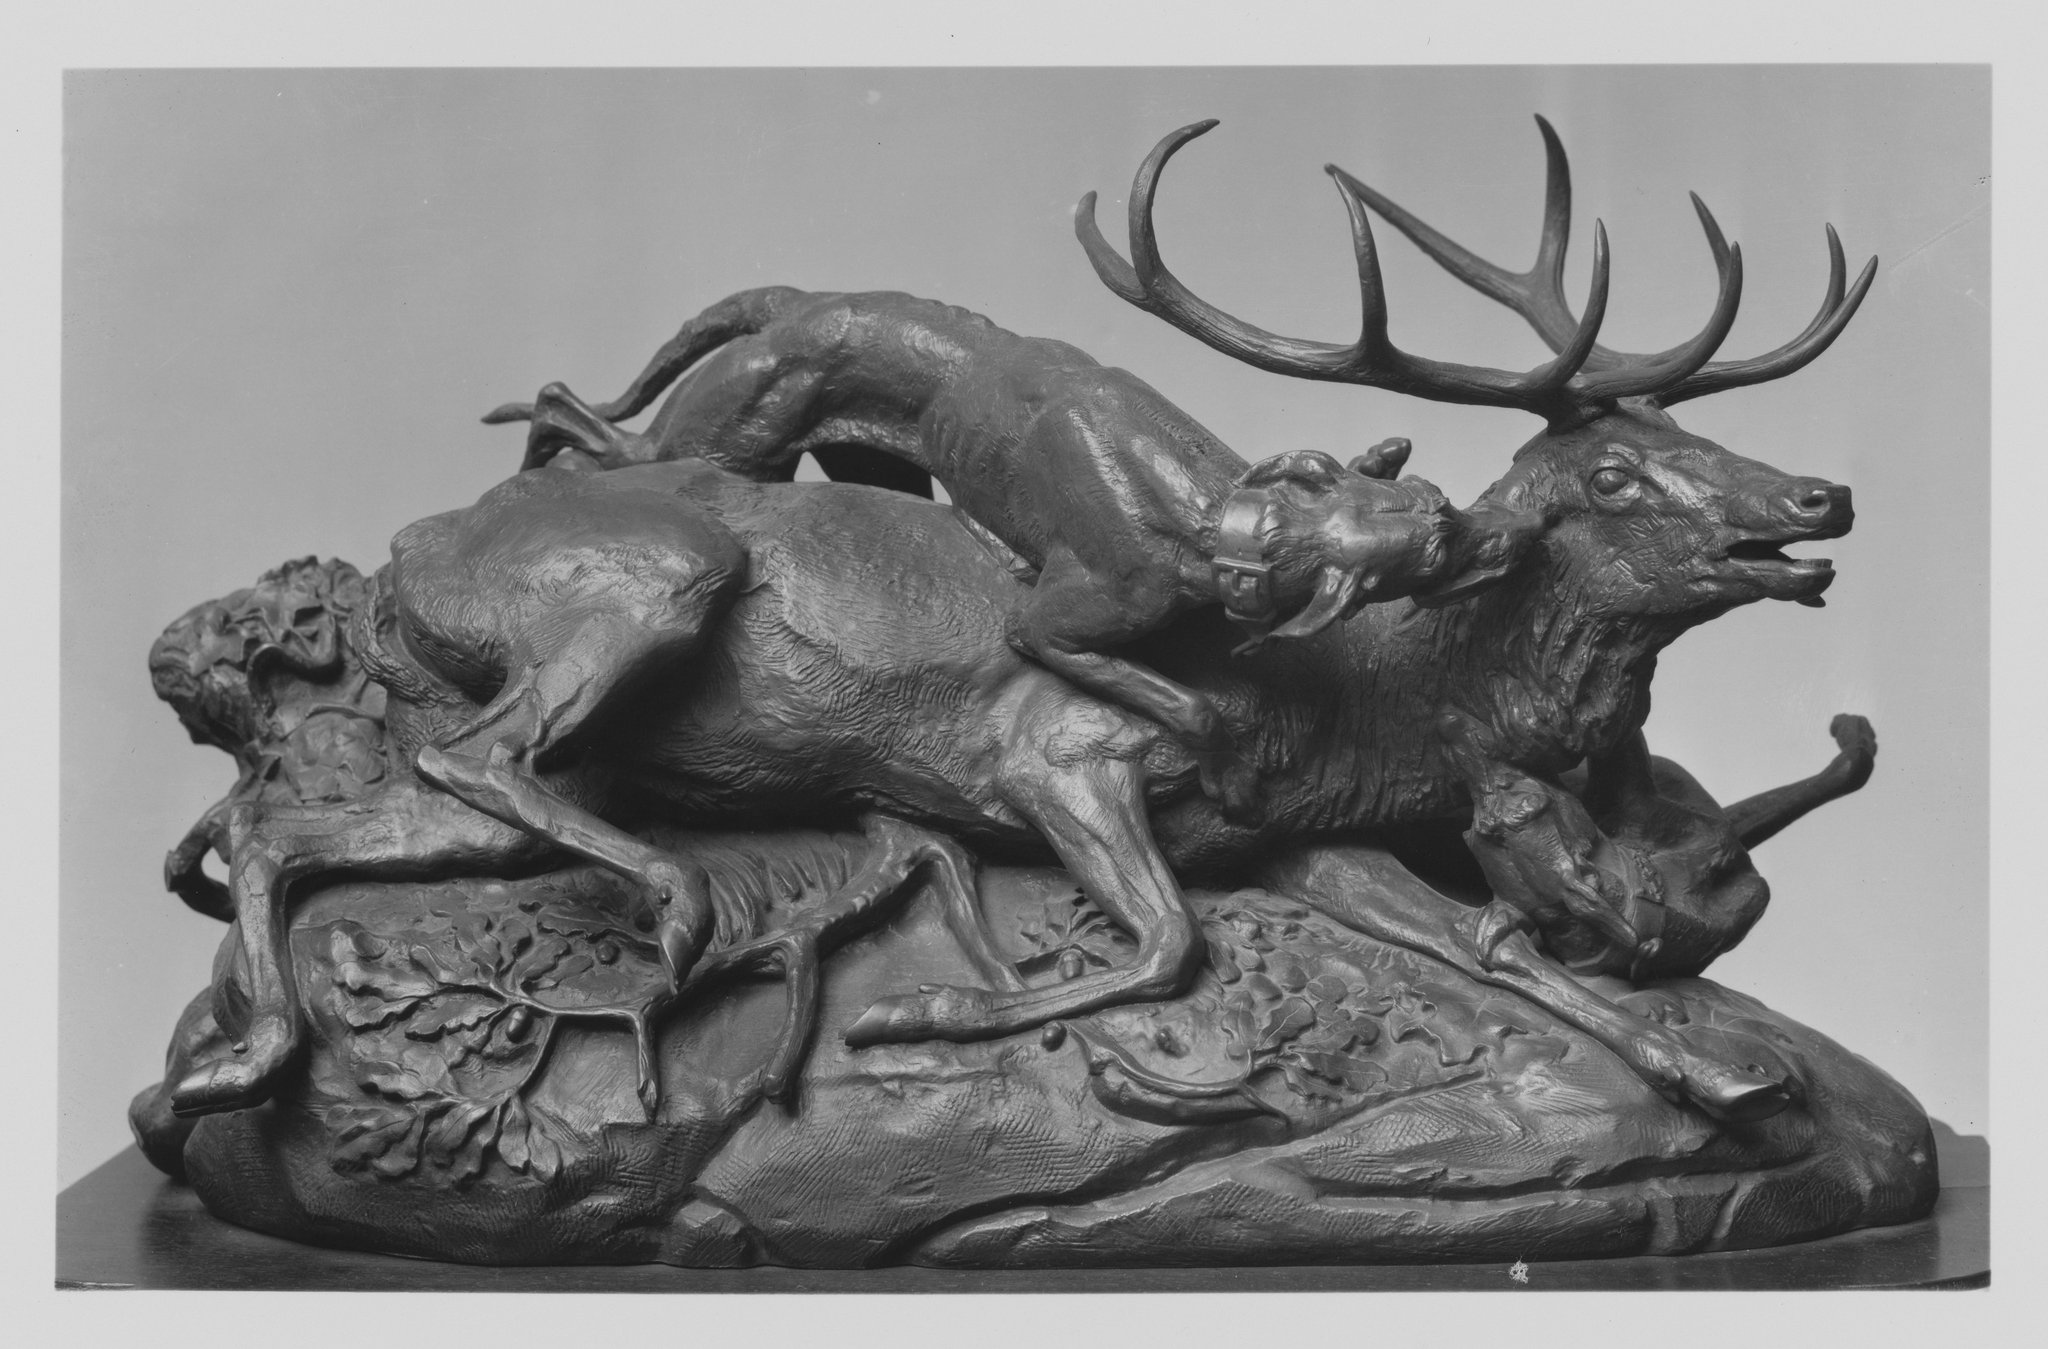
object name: statuette group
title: Ten-Point Stag Brought Down by Two Scotch Hounds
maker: antoine-louis barye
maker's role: artist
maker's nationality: french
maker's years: 1795-1875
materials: bronze, wood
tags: hunting,deer,dogs